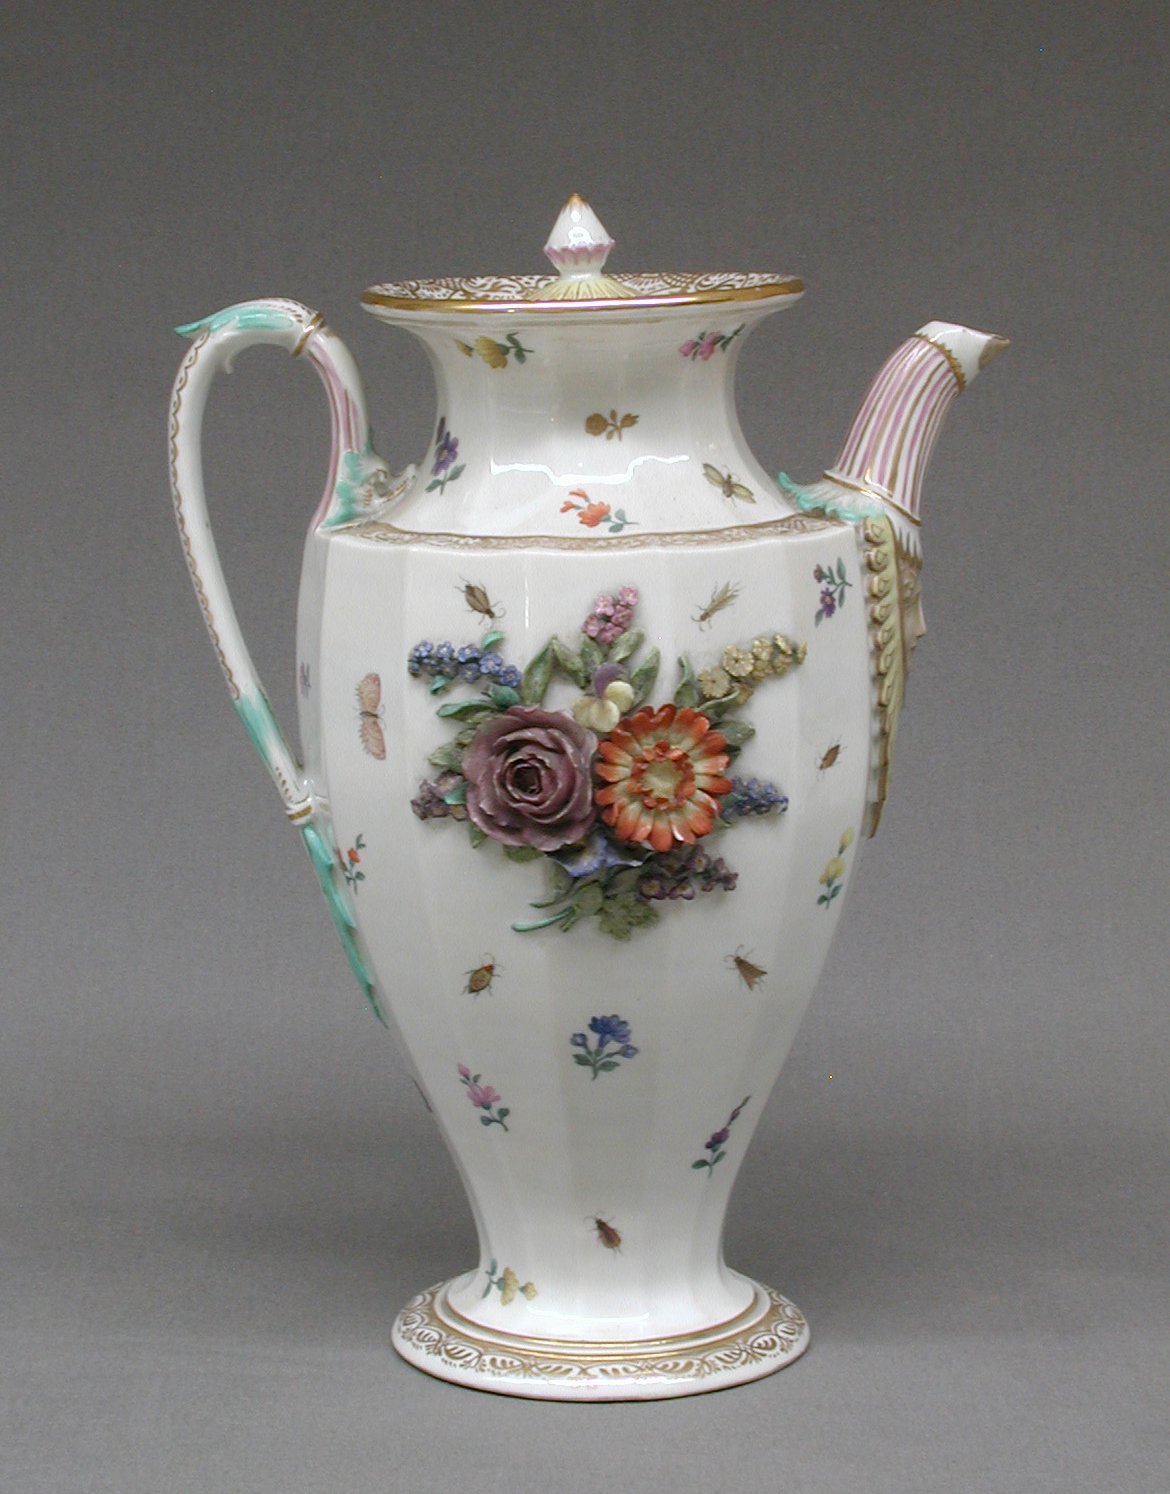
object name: coffeepot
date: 1801-1900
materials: hard paste porcelain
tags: roses